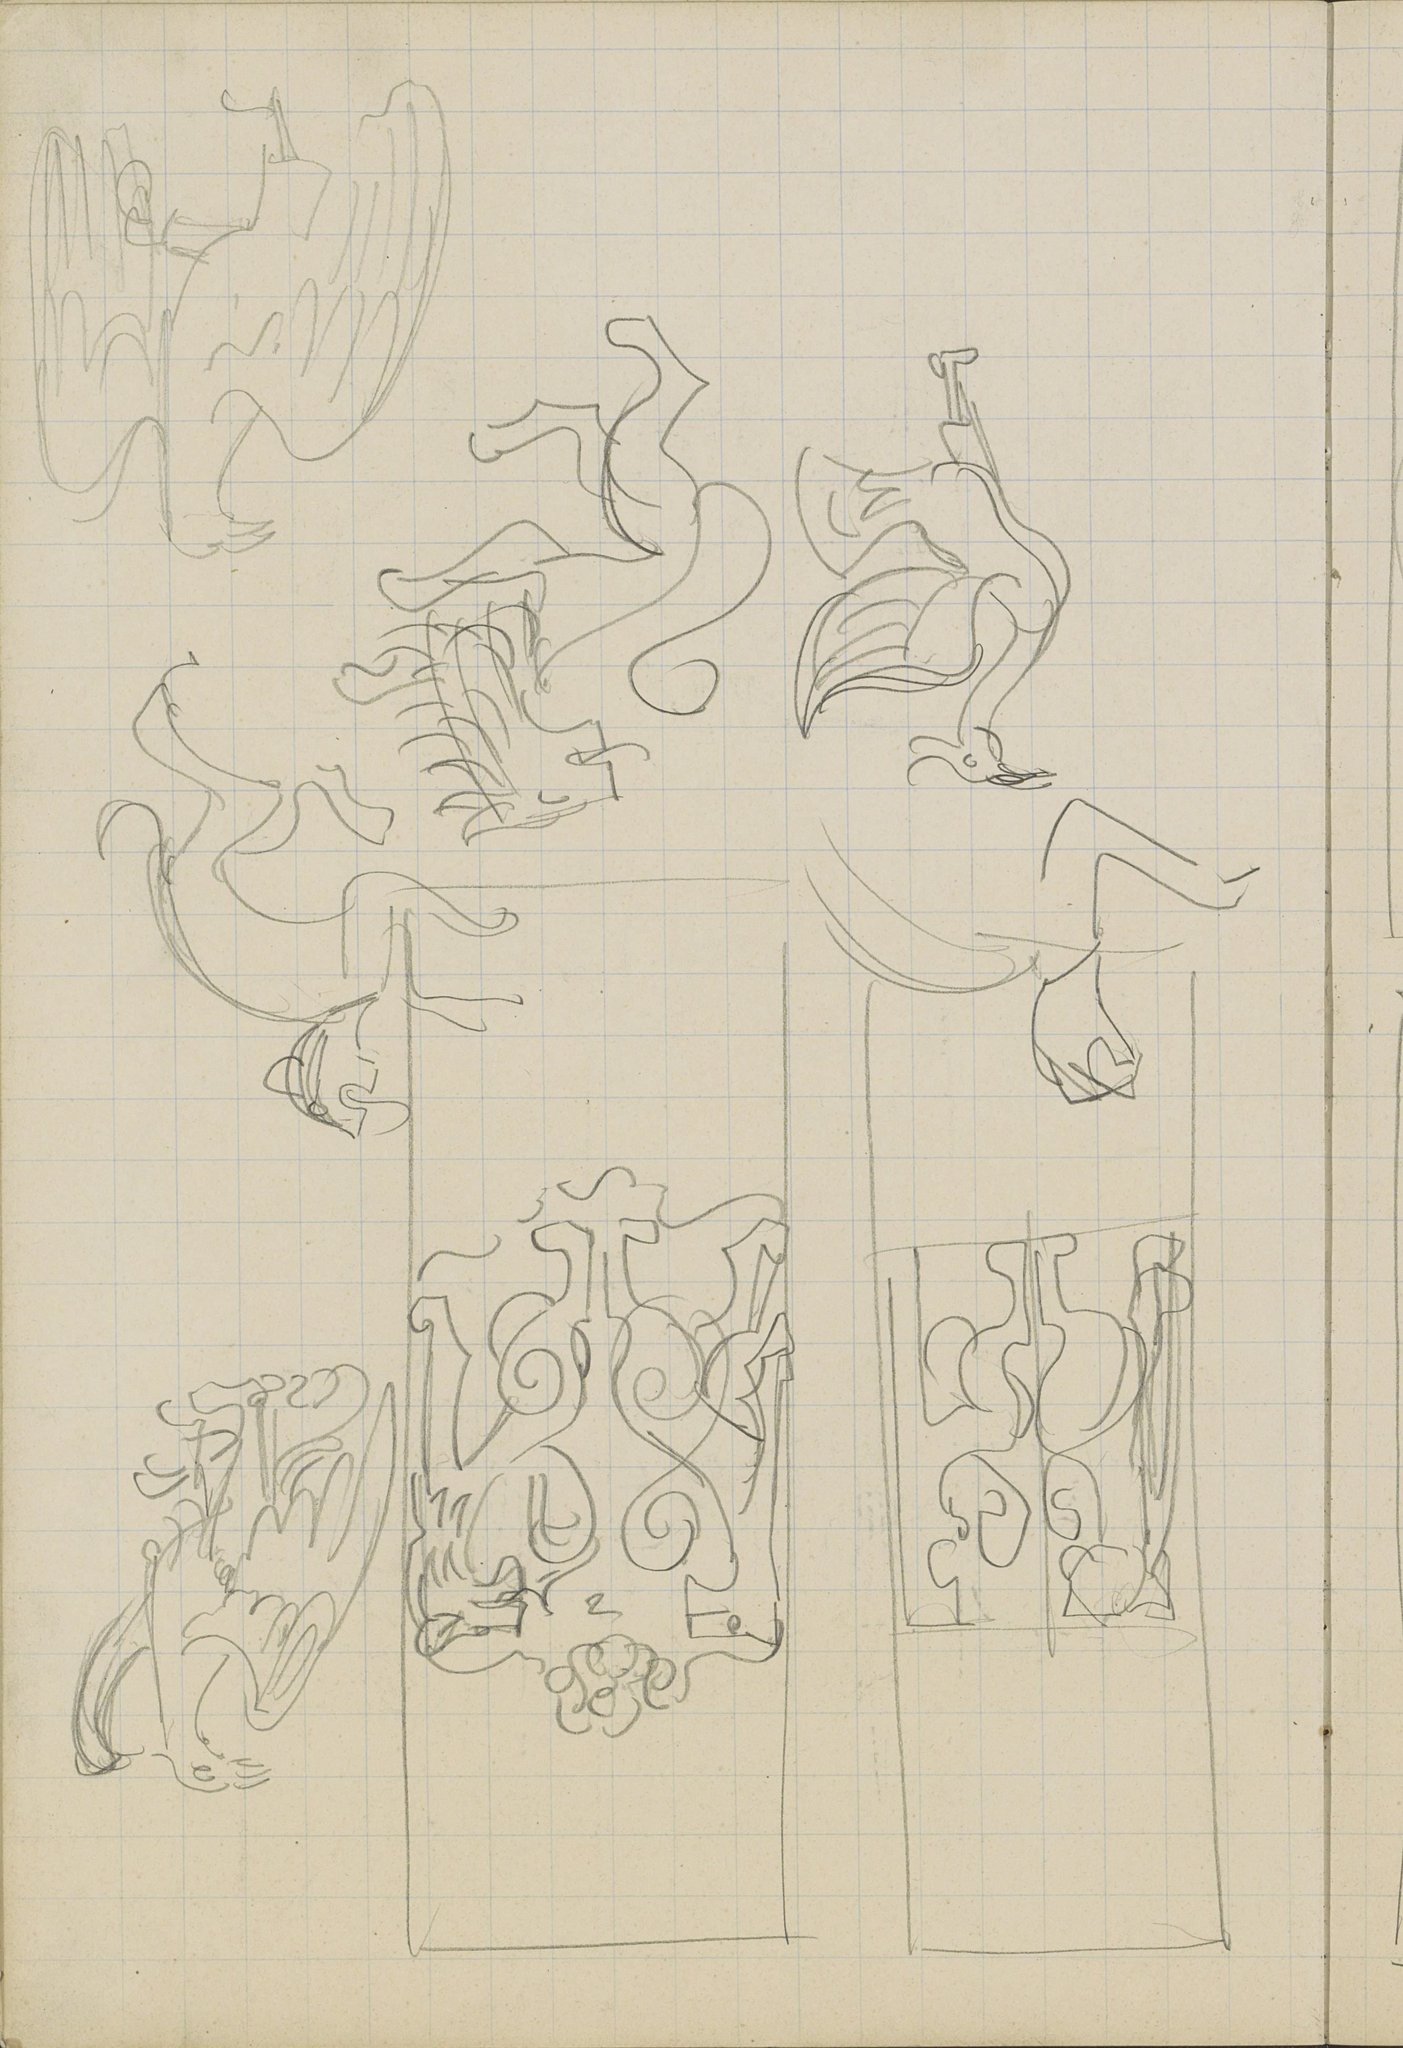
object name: sketchbook leaf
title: Ornamenten met vogels en leeuwen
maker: carel adolph lion cachet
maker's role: draughtsman, print maker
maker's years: 1864-1945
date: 1925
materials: pencil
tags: ornament derived from animal forms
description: Blad 9 verso uit een schetsboek met 11 bladen.